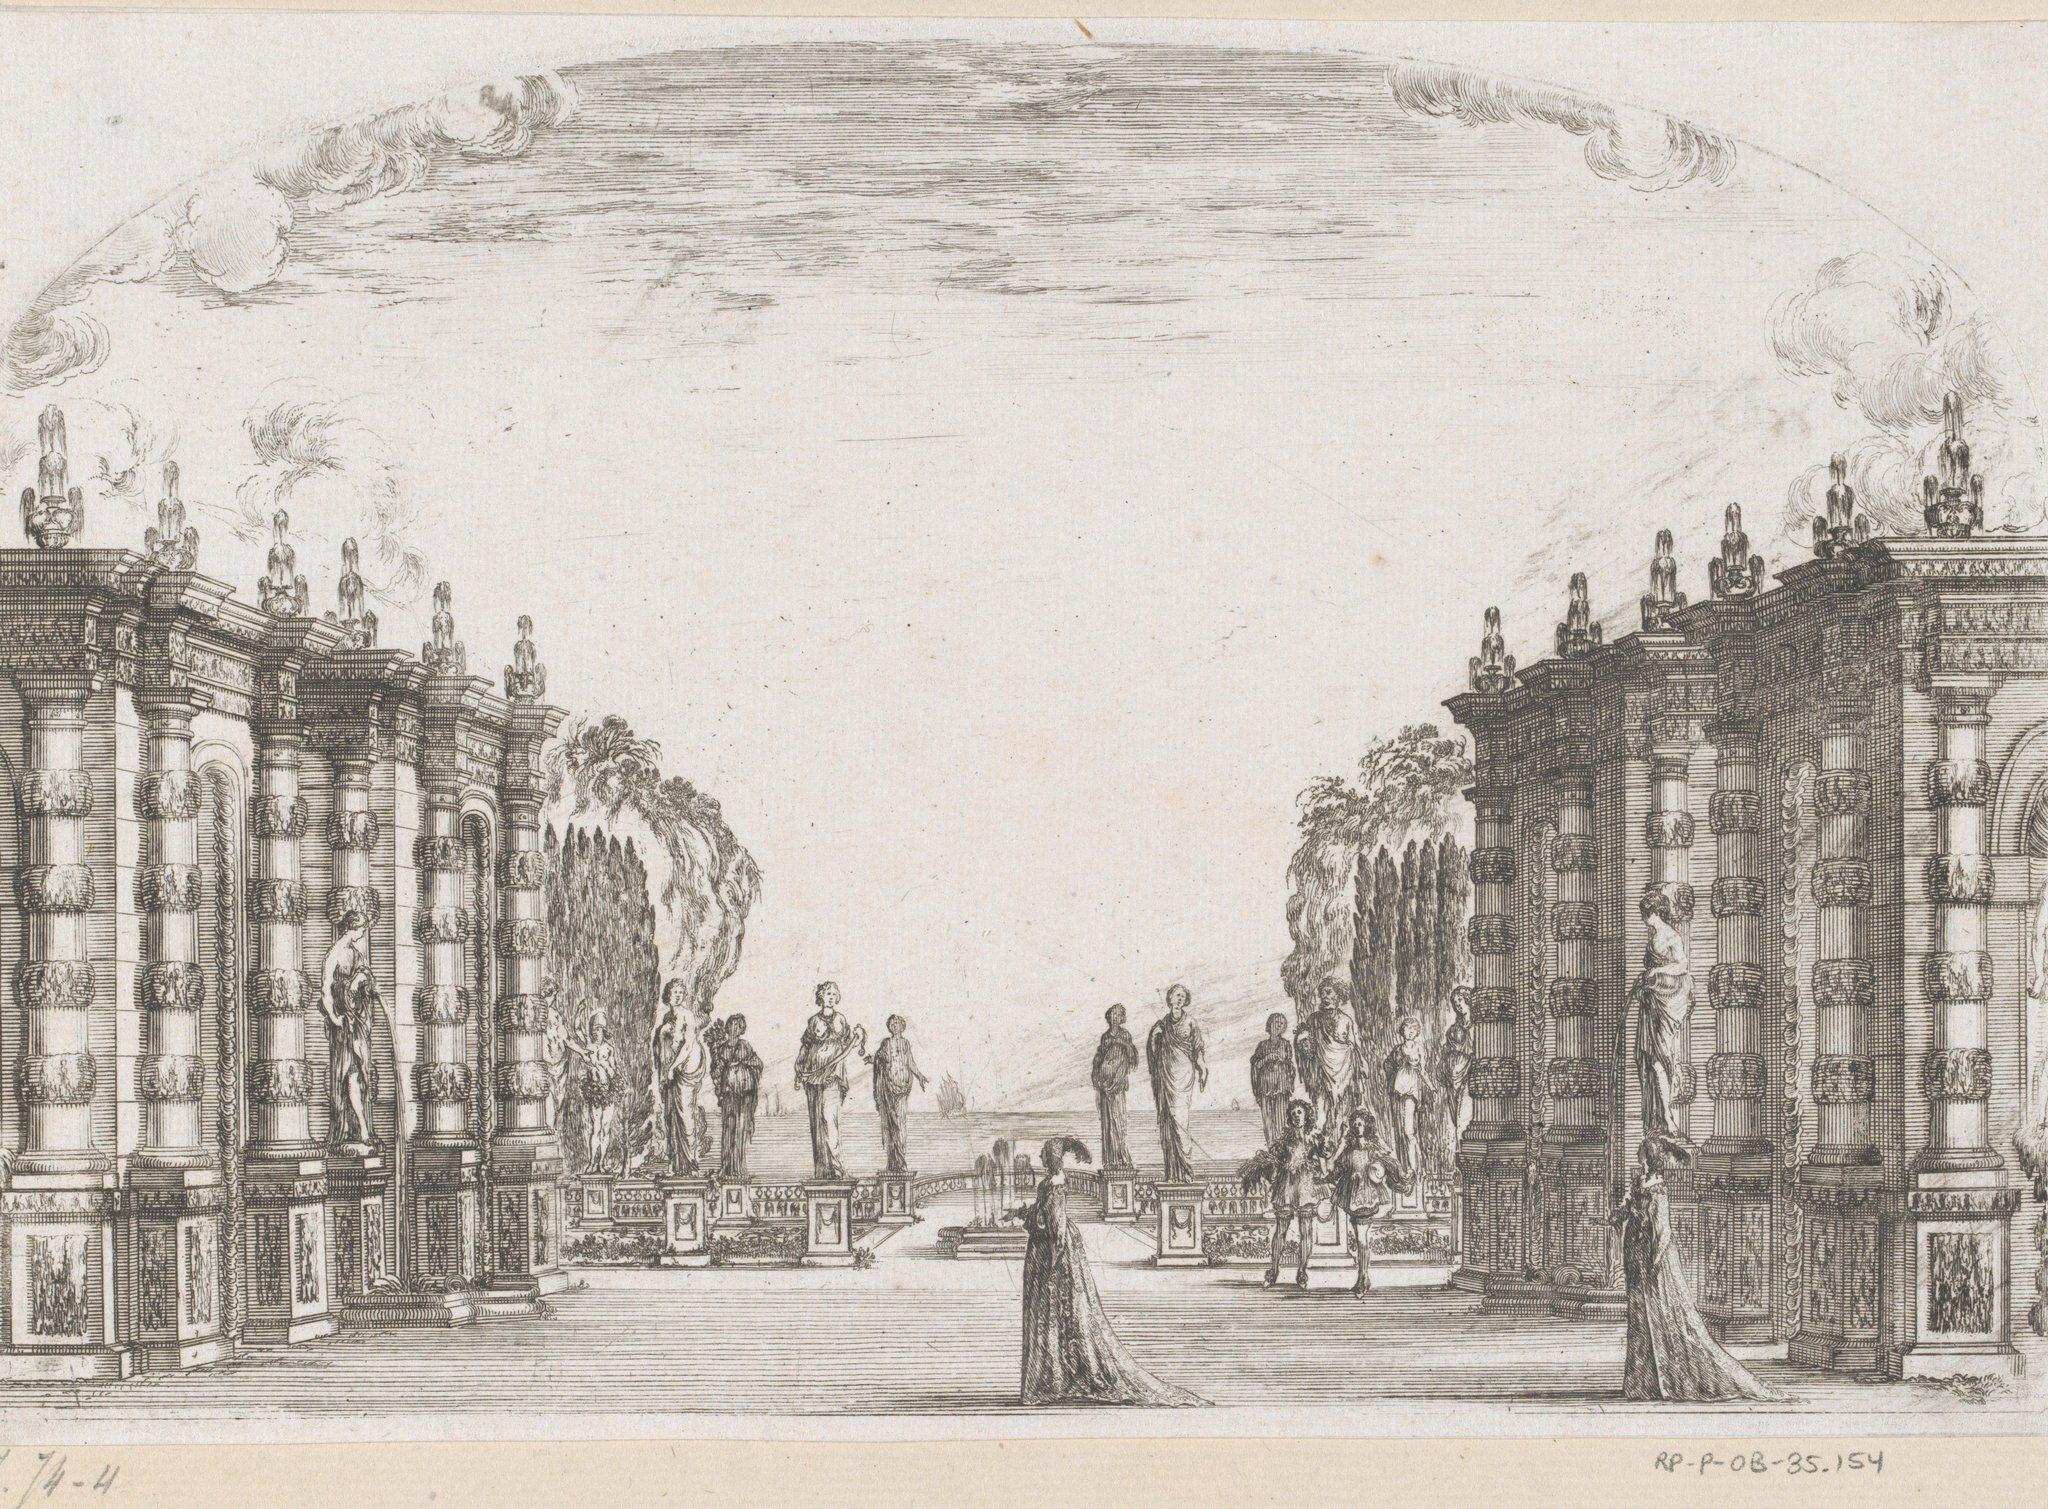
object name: print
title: Ouverture du theatre de la grande salle du palais cardinal Mirame tragicomedie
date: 1641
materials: paper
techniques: etching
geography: france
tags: set, scenery ~ stage, actor (on the stage)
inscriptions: collector's mark: Lugt 240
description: Zicht op een podium waar de vierde akte uit 'Mirame' met vier acteurs wordt opgevoerd. Het decor is een tuin met beelden aan zee.